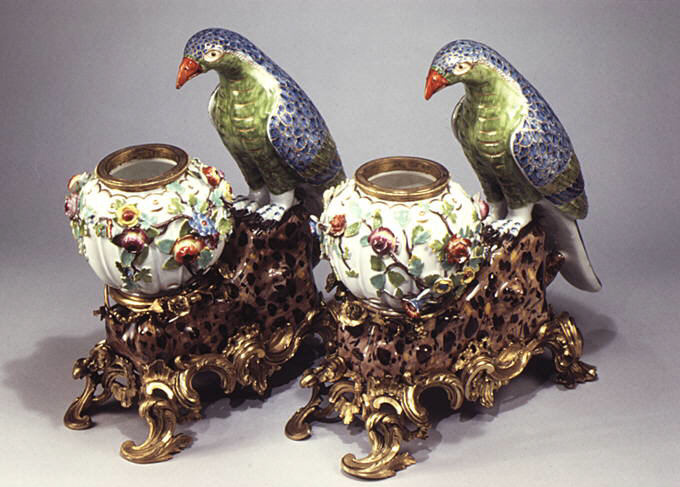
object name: figure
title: Parrot (one of a pair)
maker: meissen manufactory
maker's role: manufactory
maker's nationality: german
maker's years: 1710-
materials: hard paste porcelain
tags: parrots,flowers,leaves